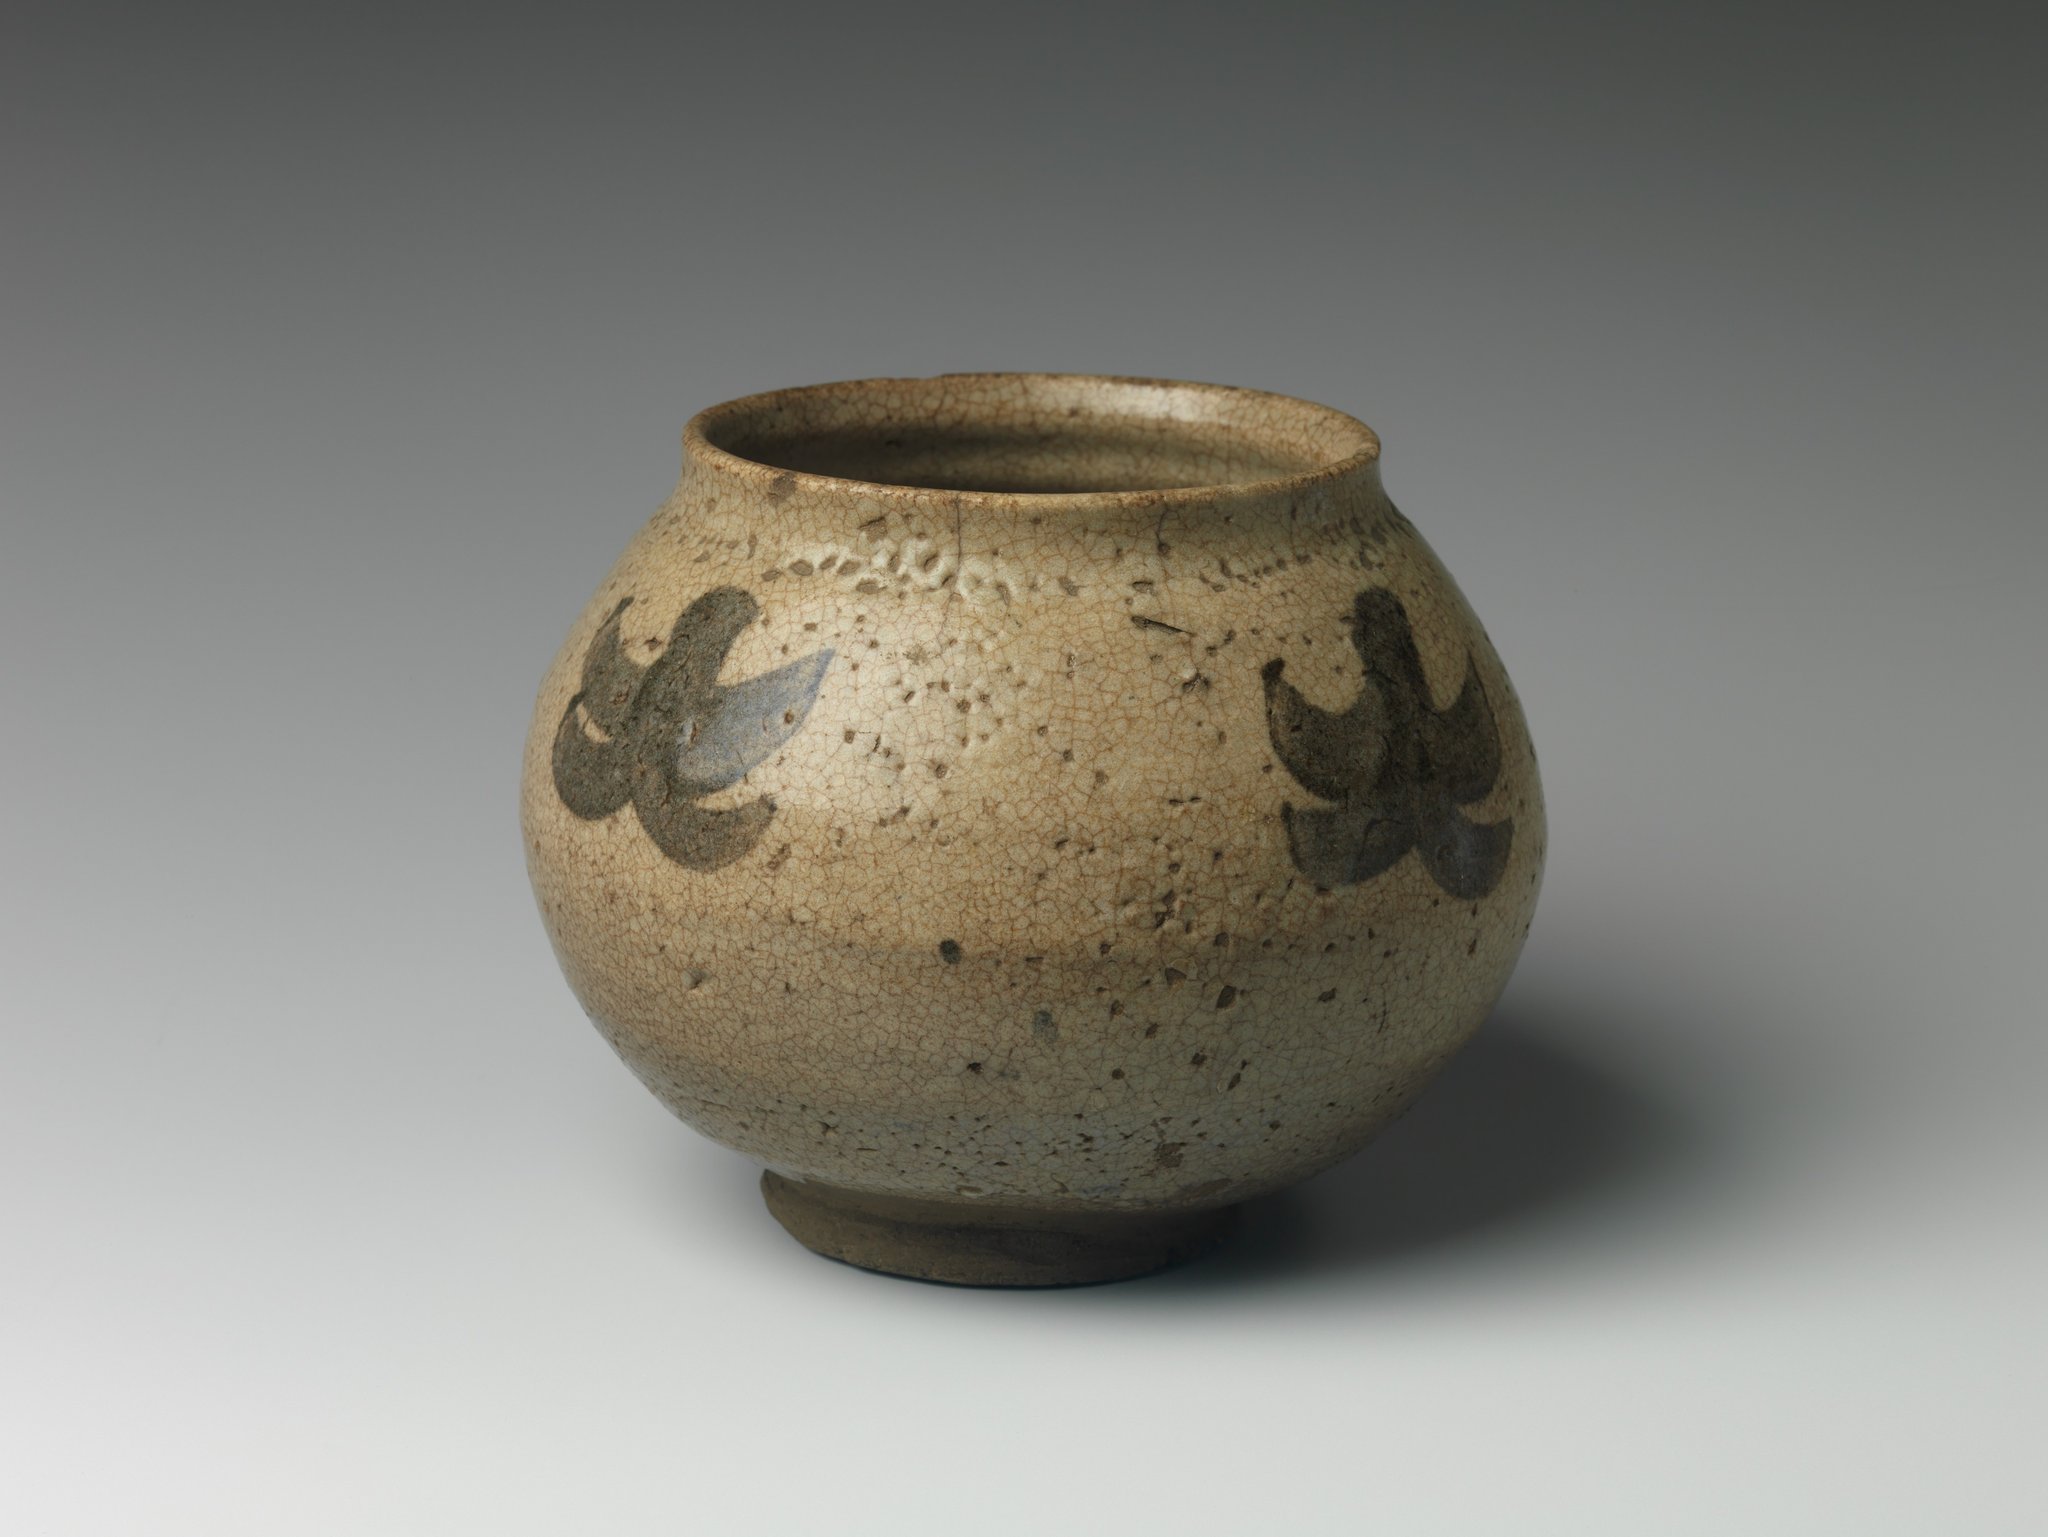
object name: jar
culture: japanese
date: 1573-1615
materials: iron, stoneware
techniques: painting, underglaze